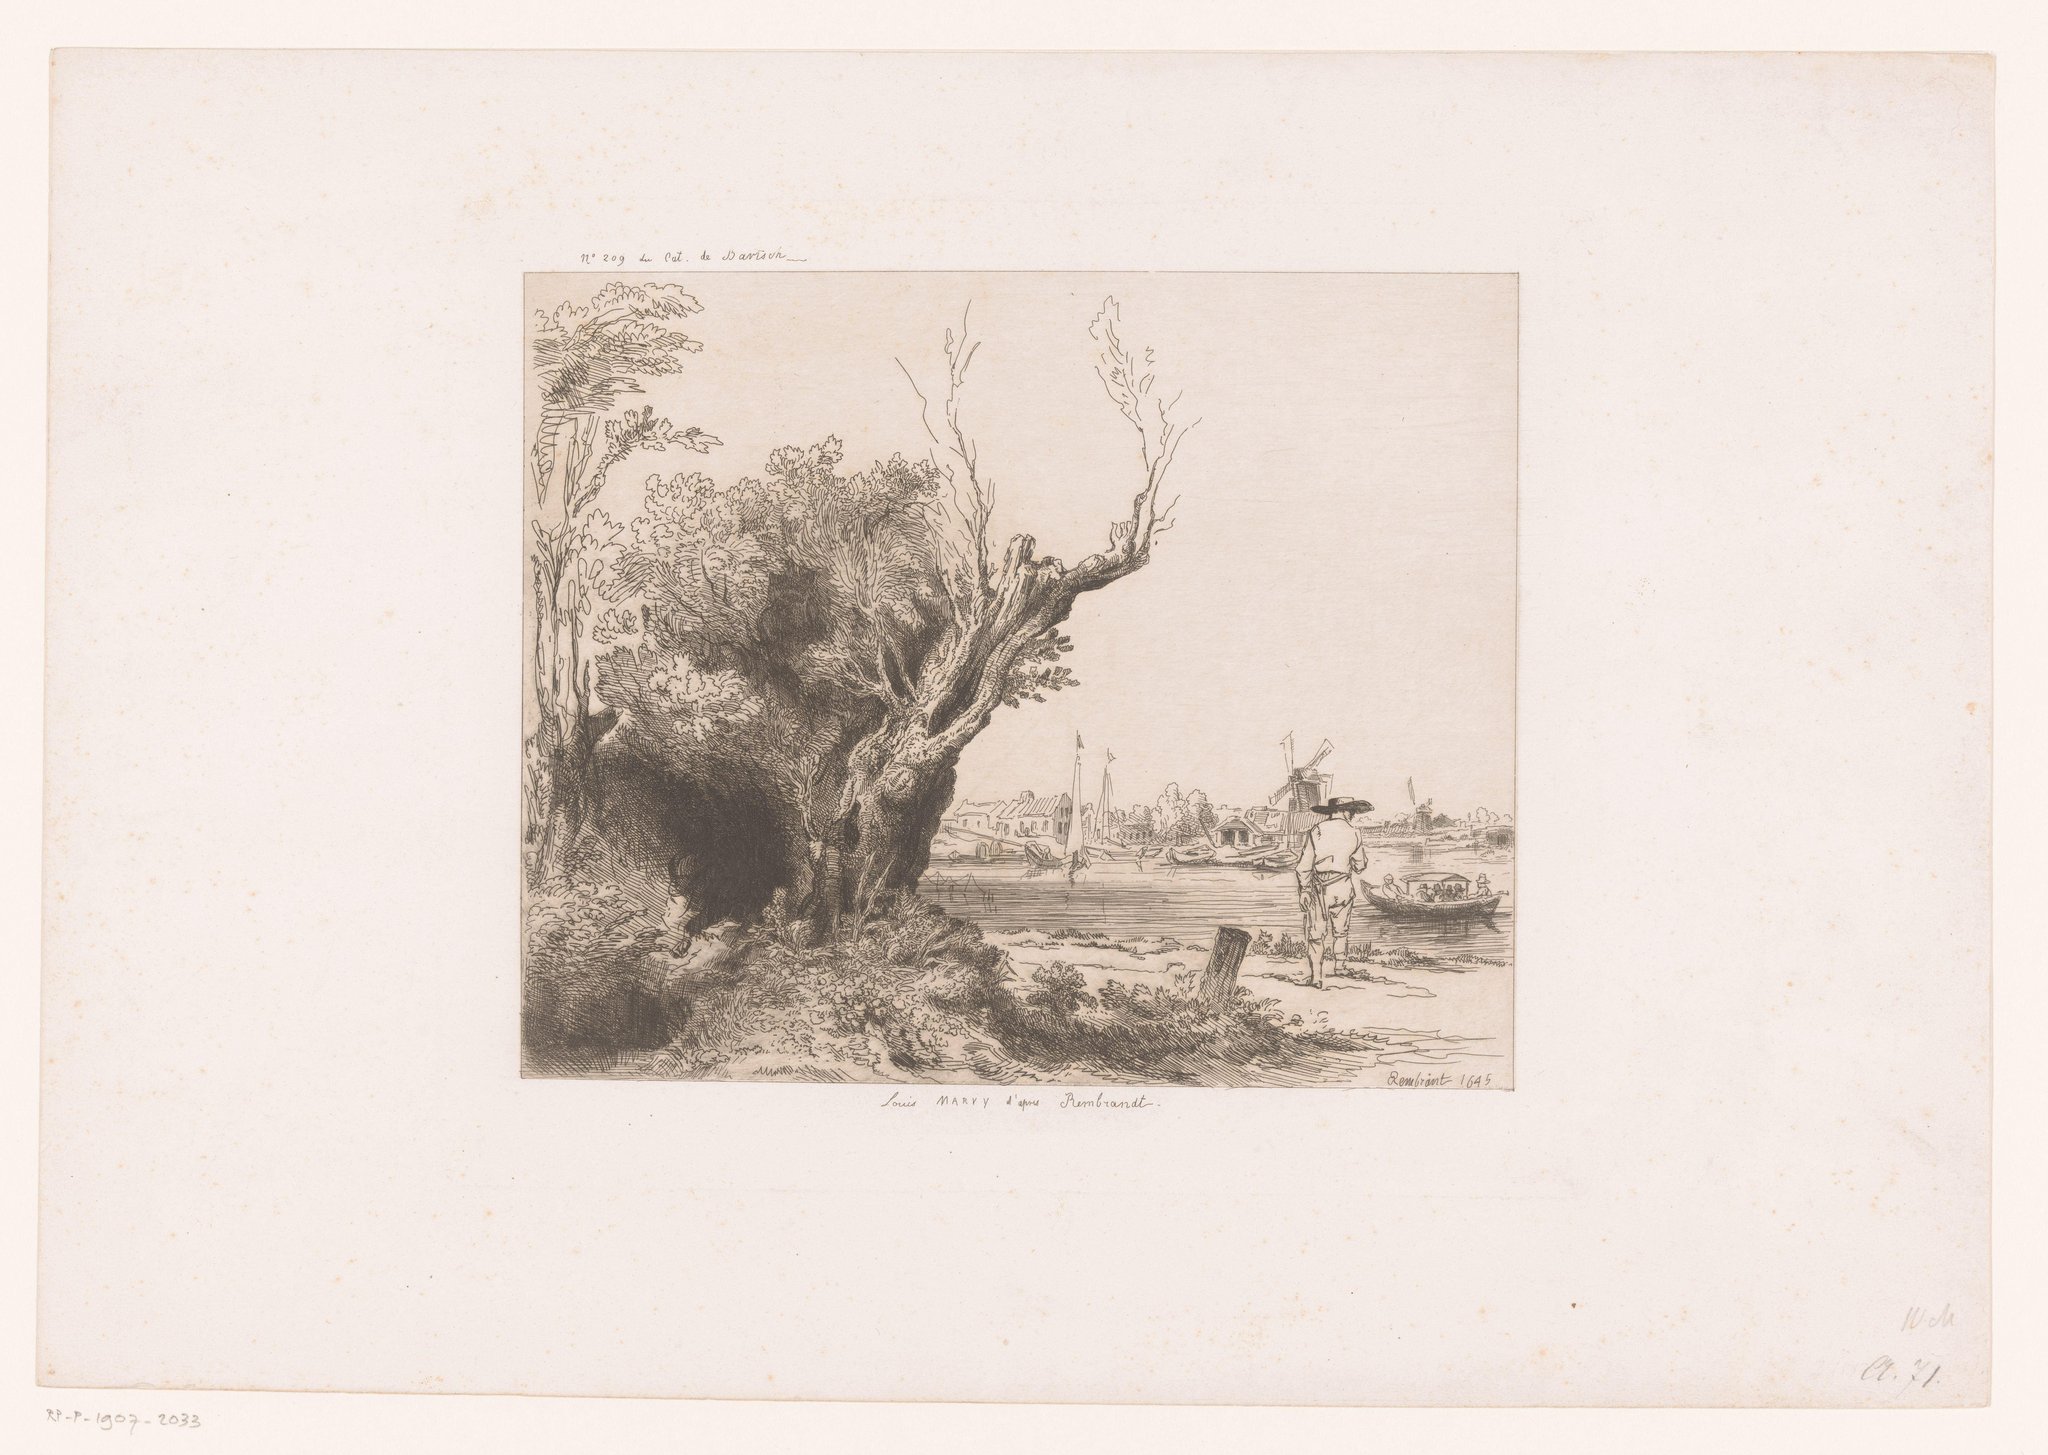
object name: print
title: Het spelonkje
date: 1825-1850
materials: paper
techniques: etching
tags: river, cave, grotto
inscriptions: check stamp, collector's mark: Lugt 2228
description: Genummerd linksboven: No. 209 du Cat. de Bartsch.